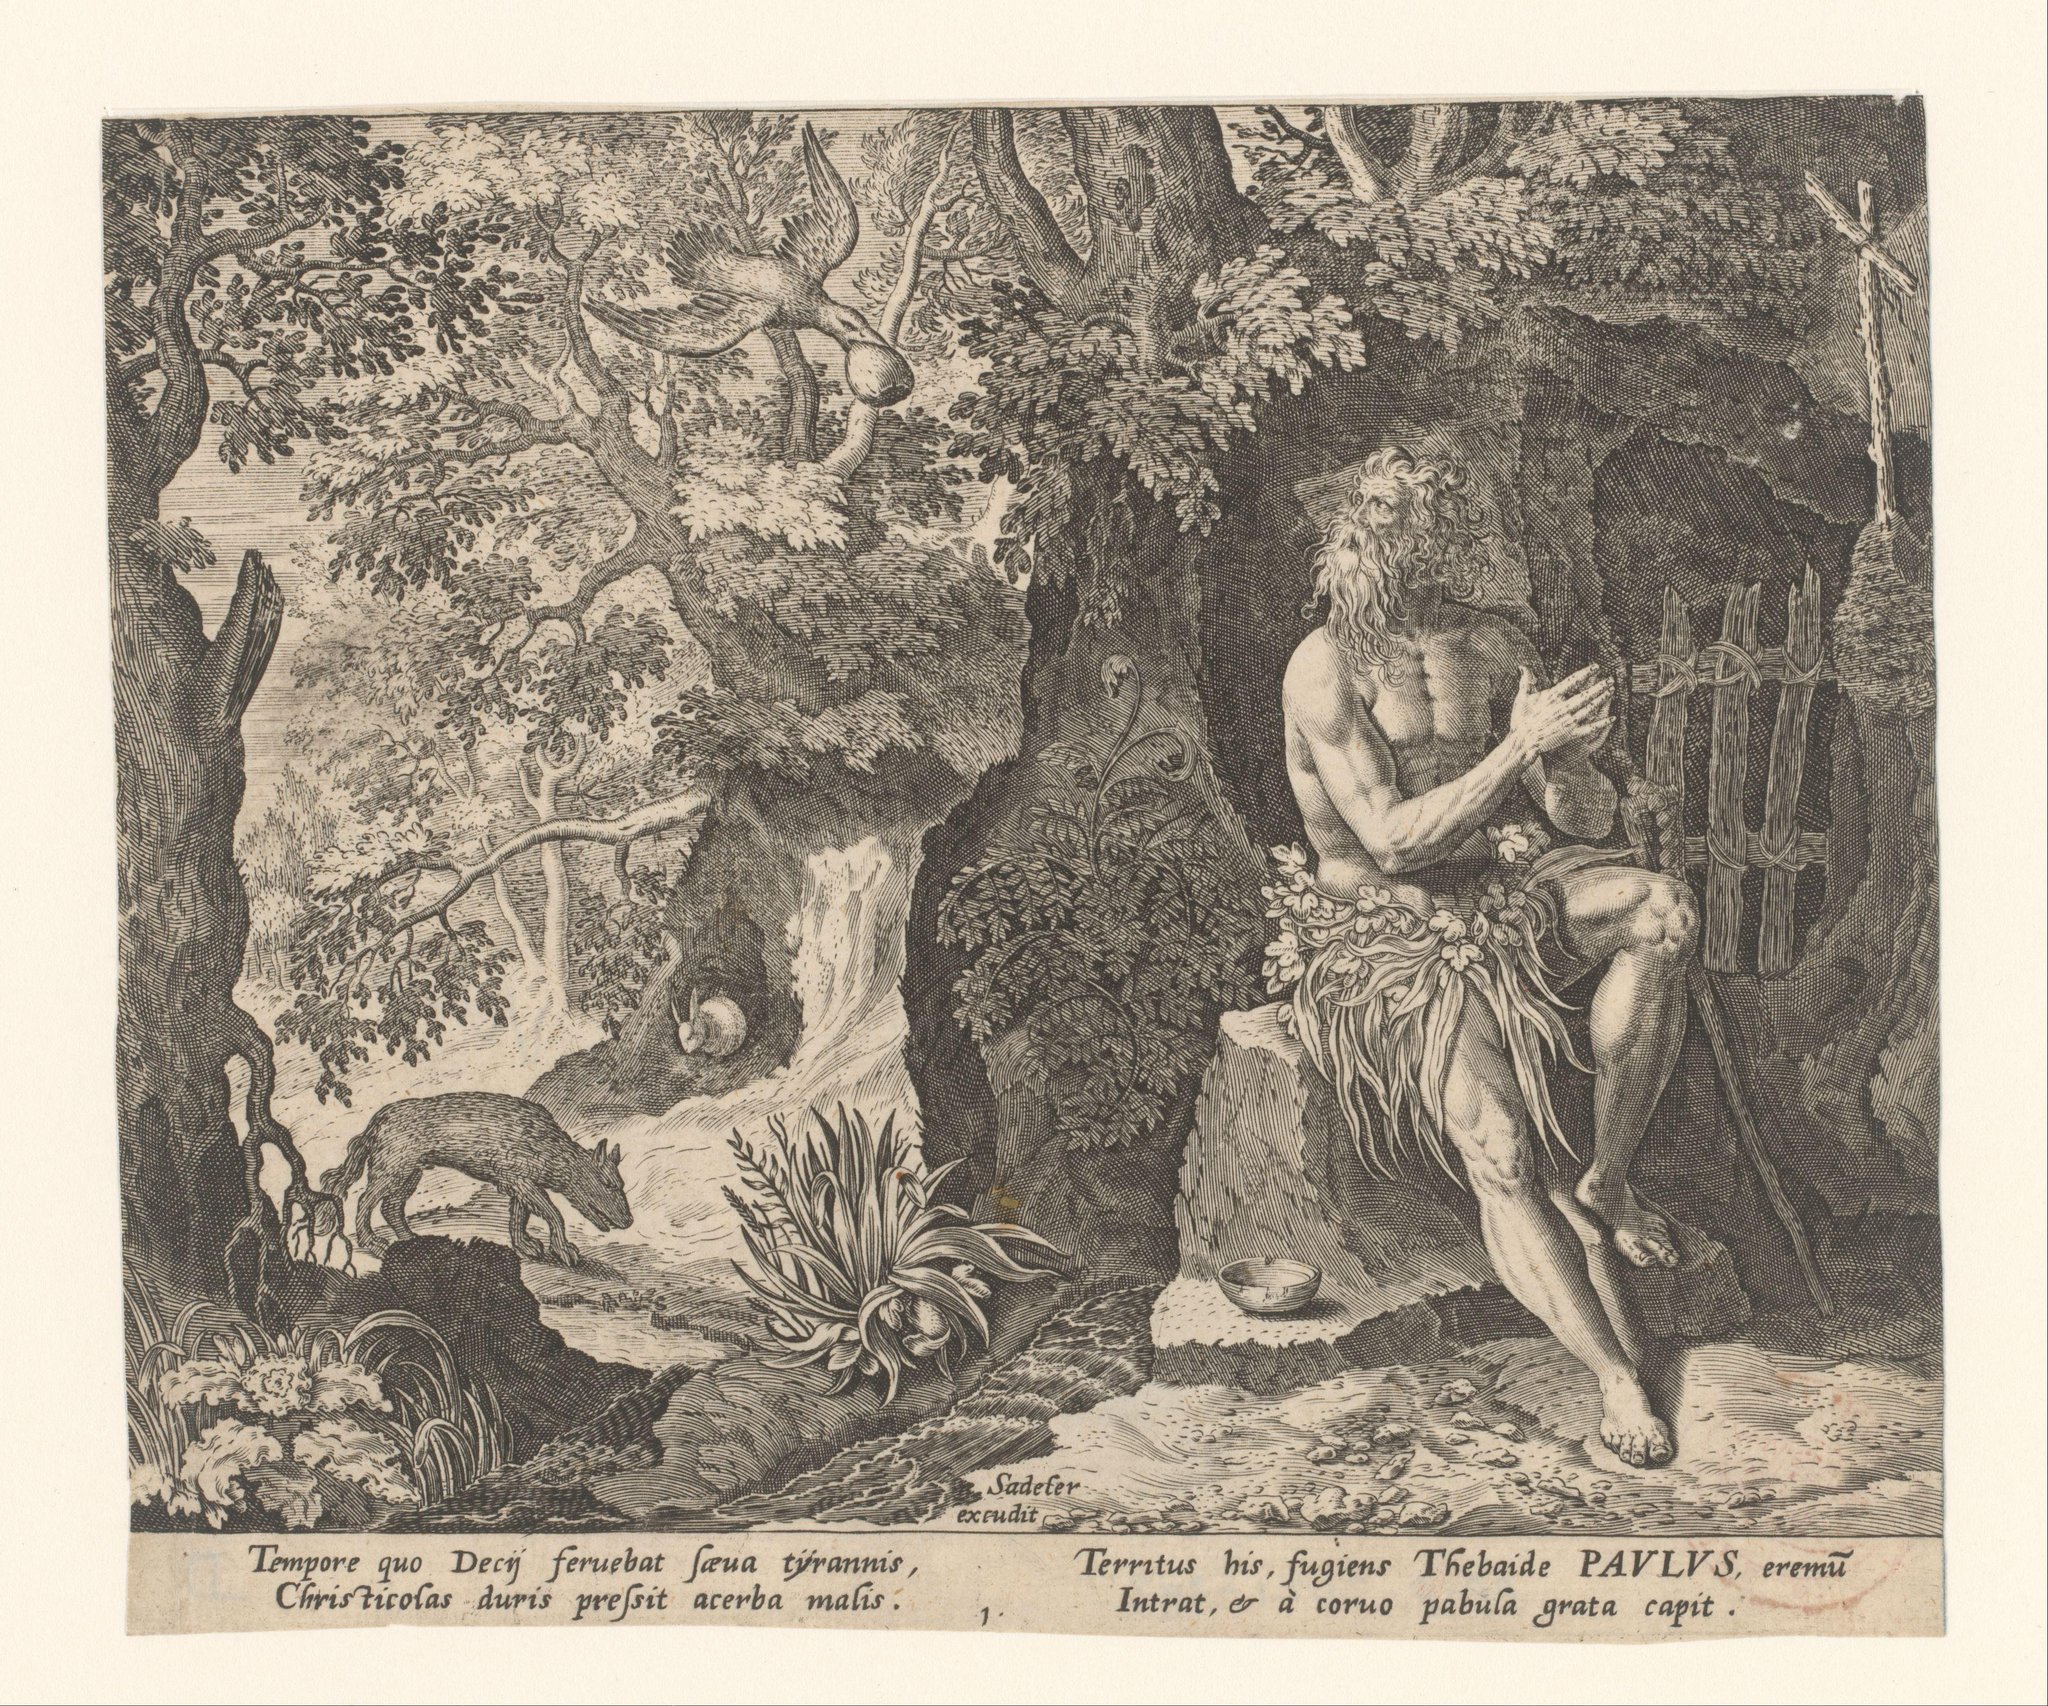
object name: print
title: Mannelijke kluizenaars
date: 1585-1586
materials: paper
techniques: engraving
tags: anchorite, hermit, cave, grotto, paul of thebes, the first hermit; possible attributes: raven, two lions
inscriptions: collector's mark: Lugt 240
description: Met vierregelig vers in twee kolommen onder de voorstelling. Midden onder genummerd: 1. De H. Paulus van Thebe, de eerste heremiet, in een grot in de wildernis van Thebaïs. Hij bidt tot een crucifix. Een raaf brengt hem brood.